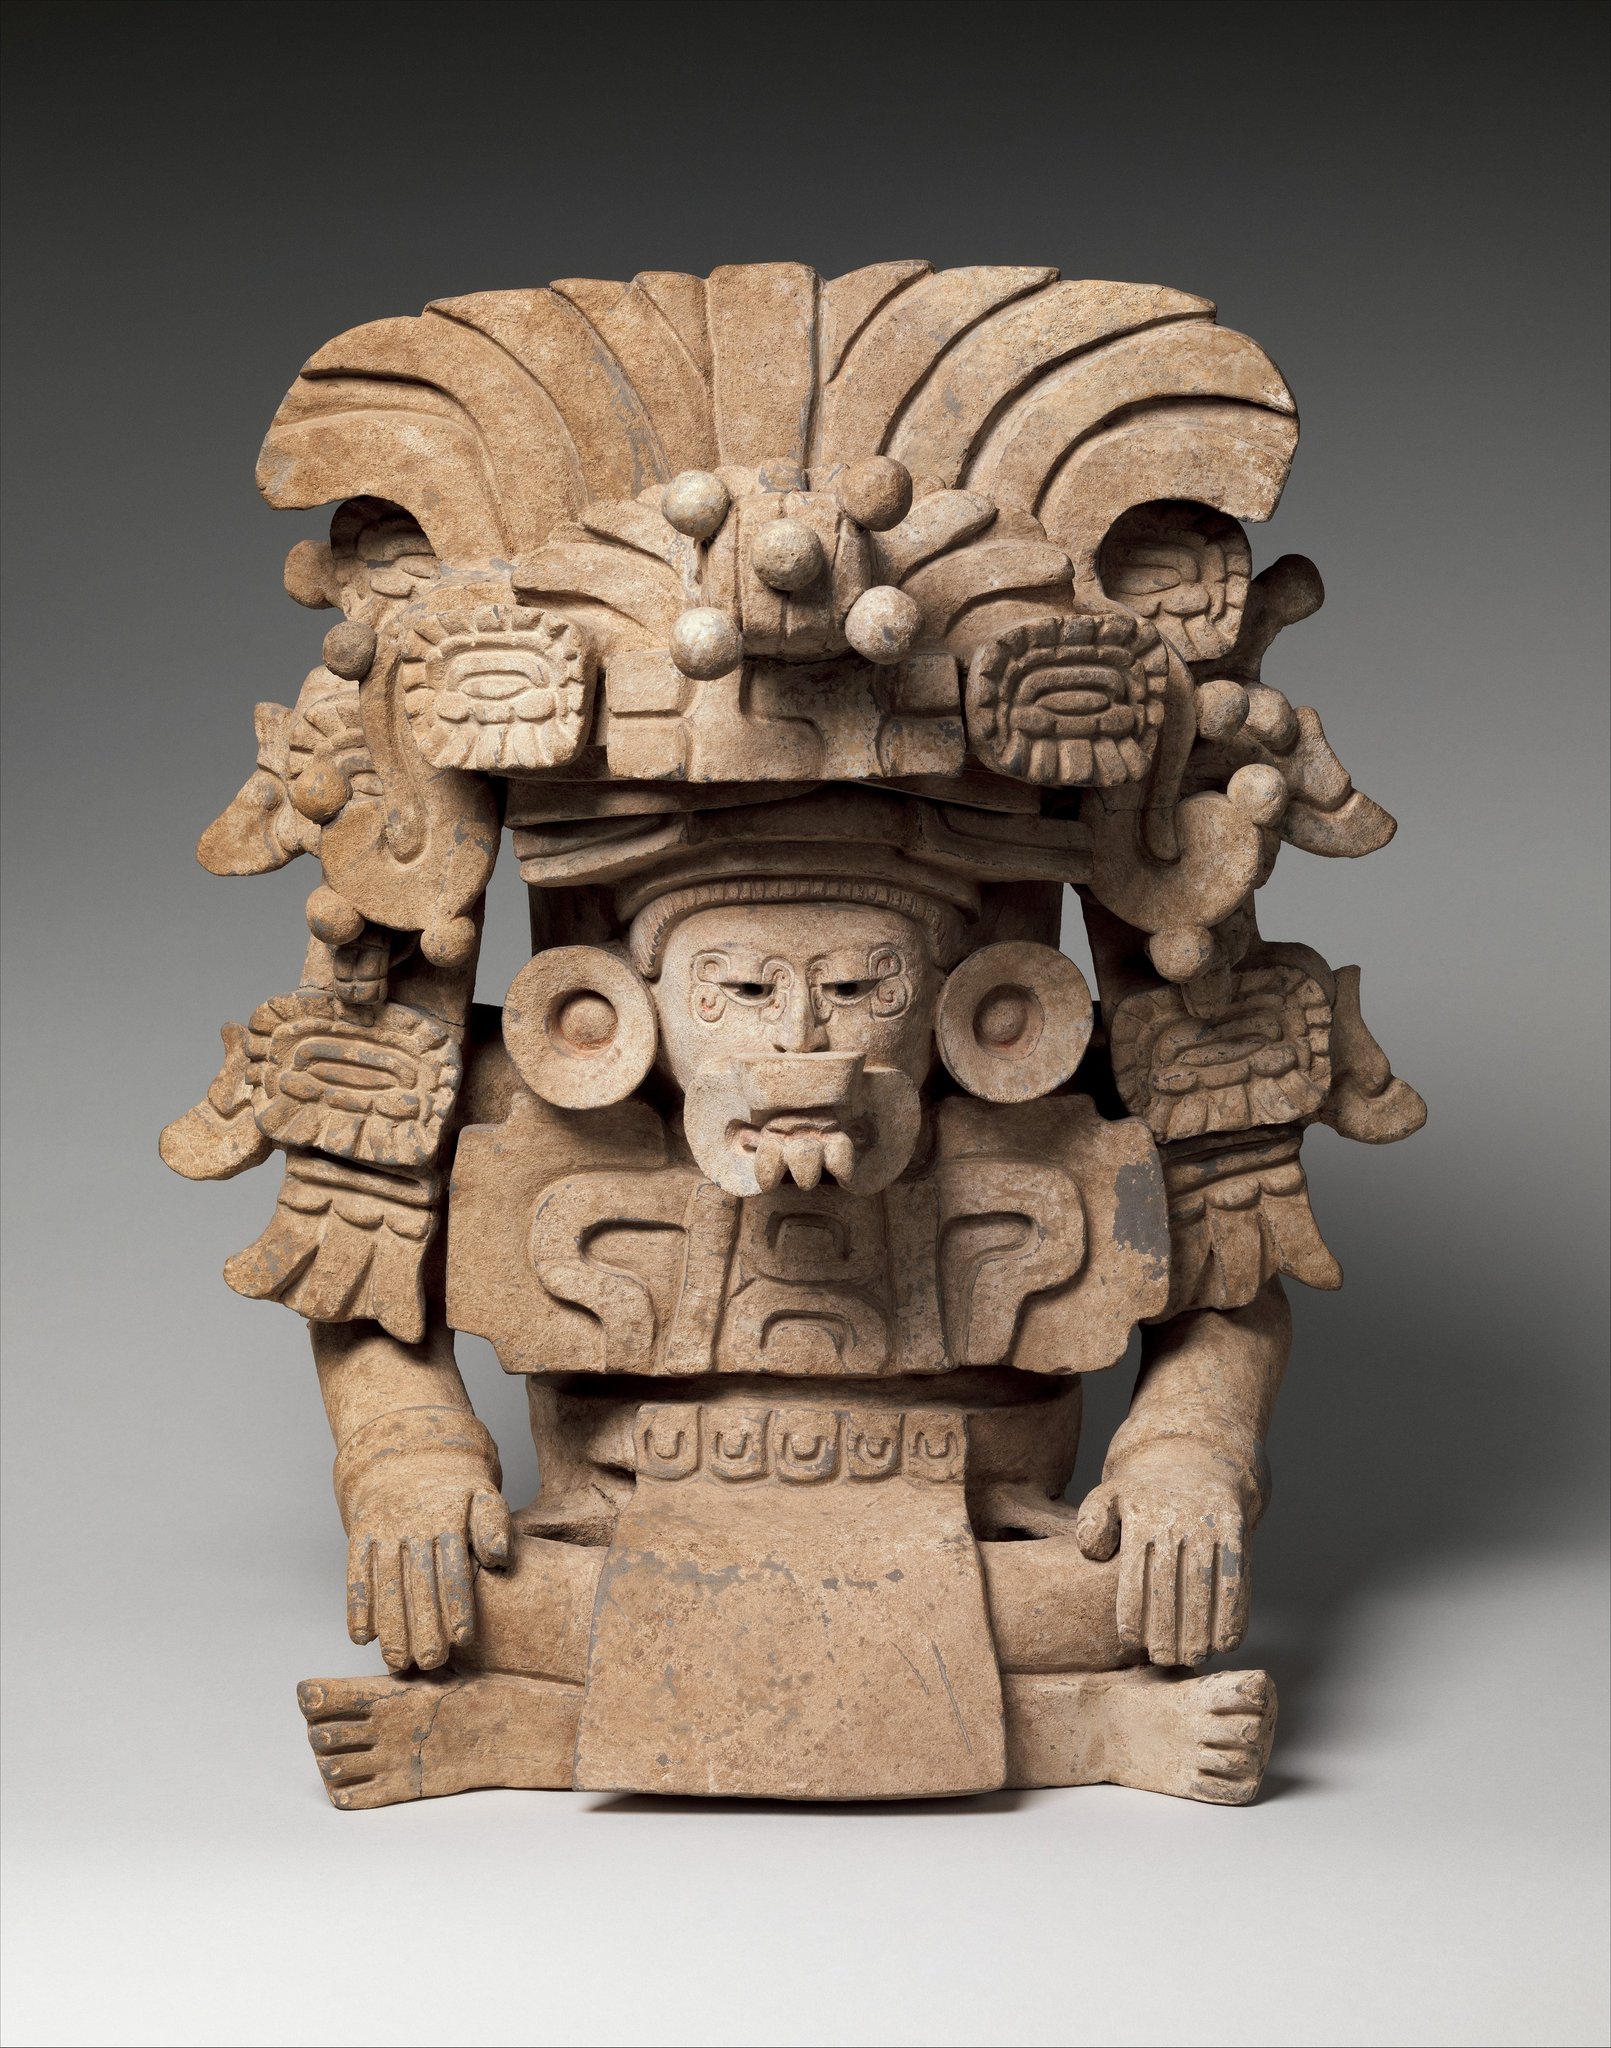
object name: urn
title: Effigy urn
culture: zapotec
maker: zapotec (be'ena'a) artist(s)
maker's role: artist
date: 350-600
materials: ceramic, pigment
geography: mexico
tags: deities